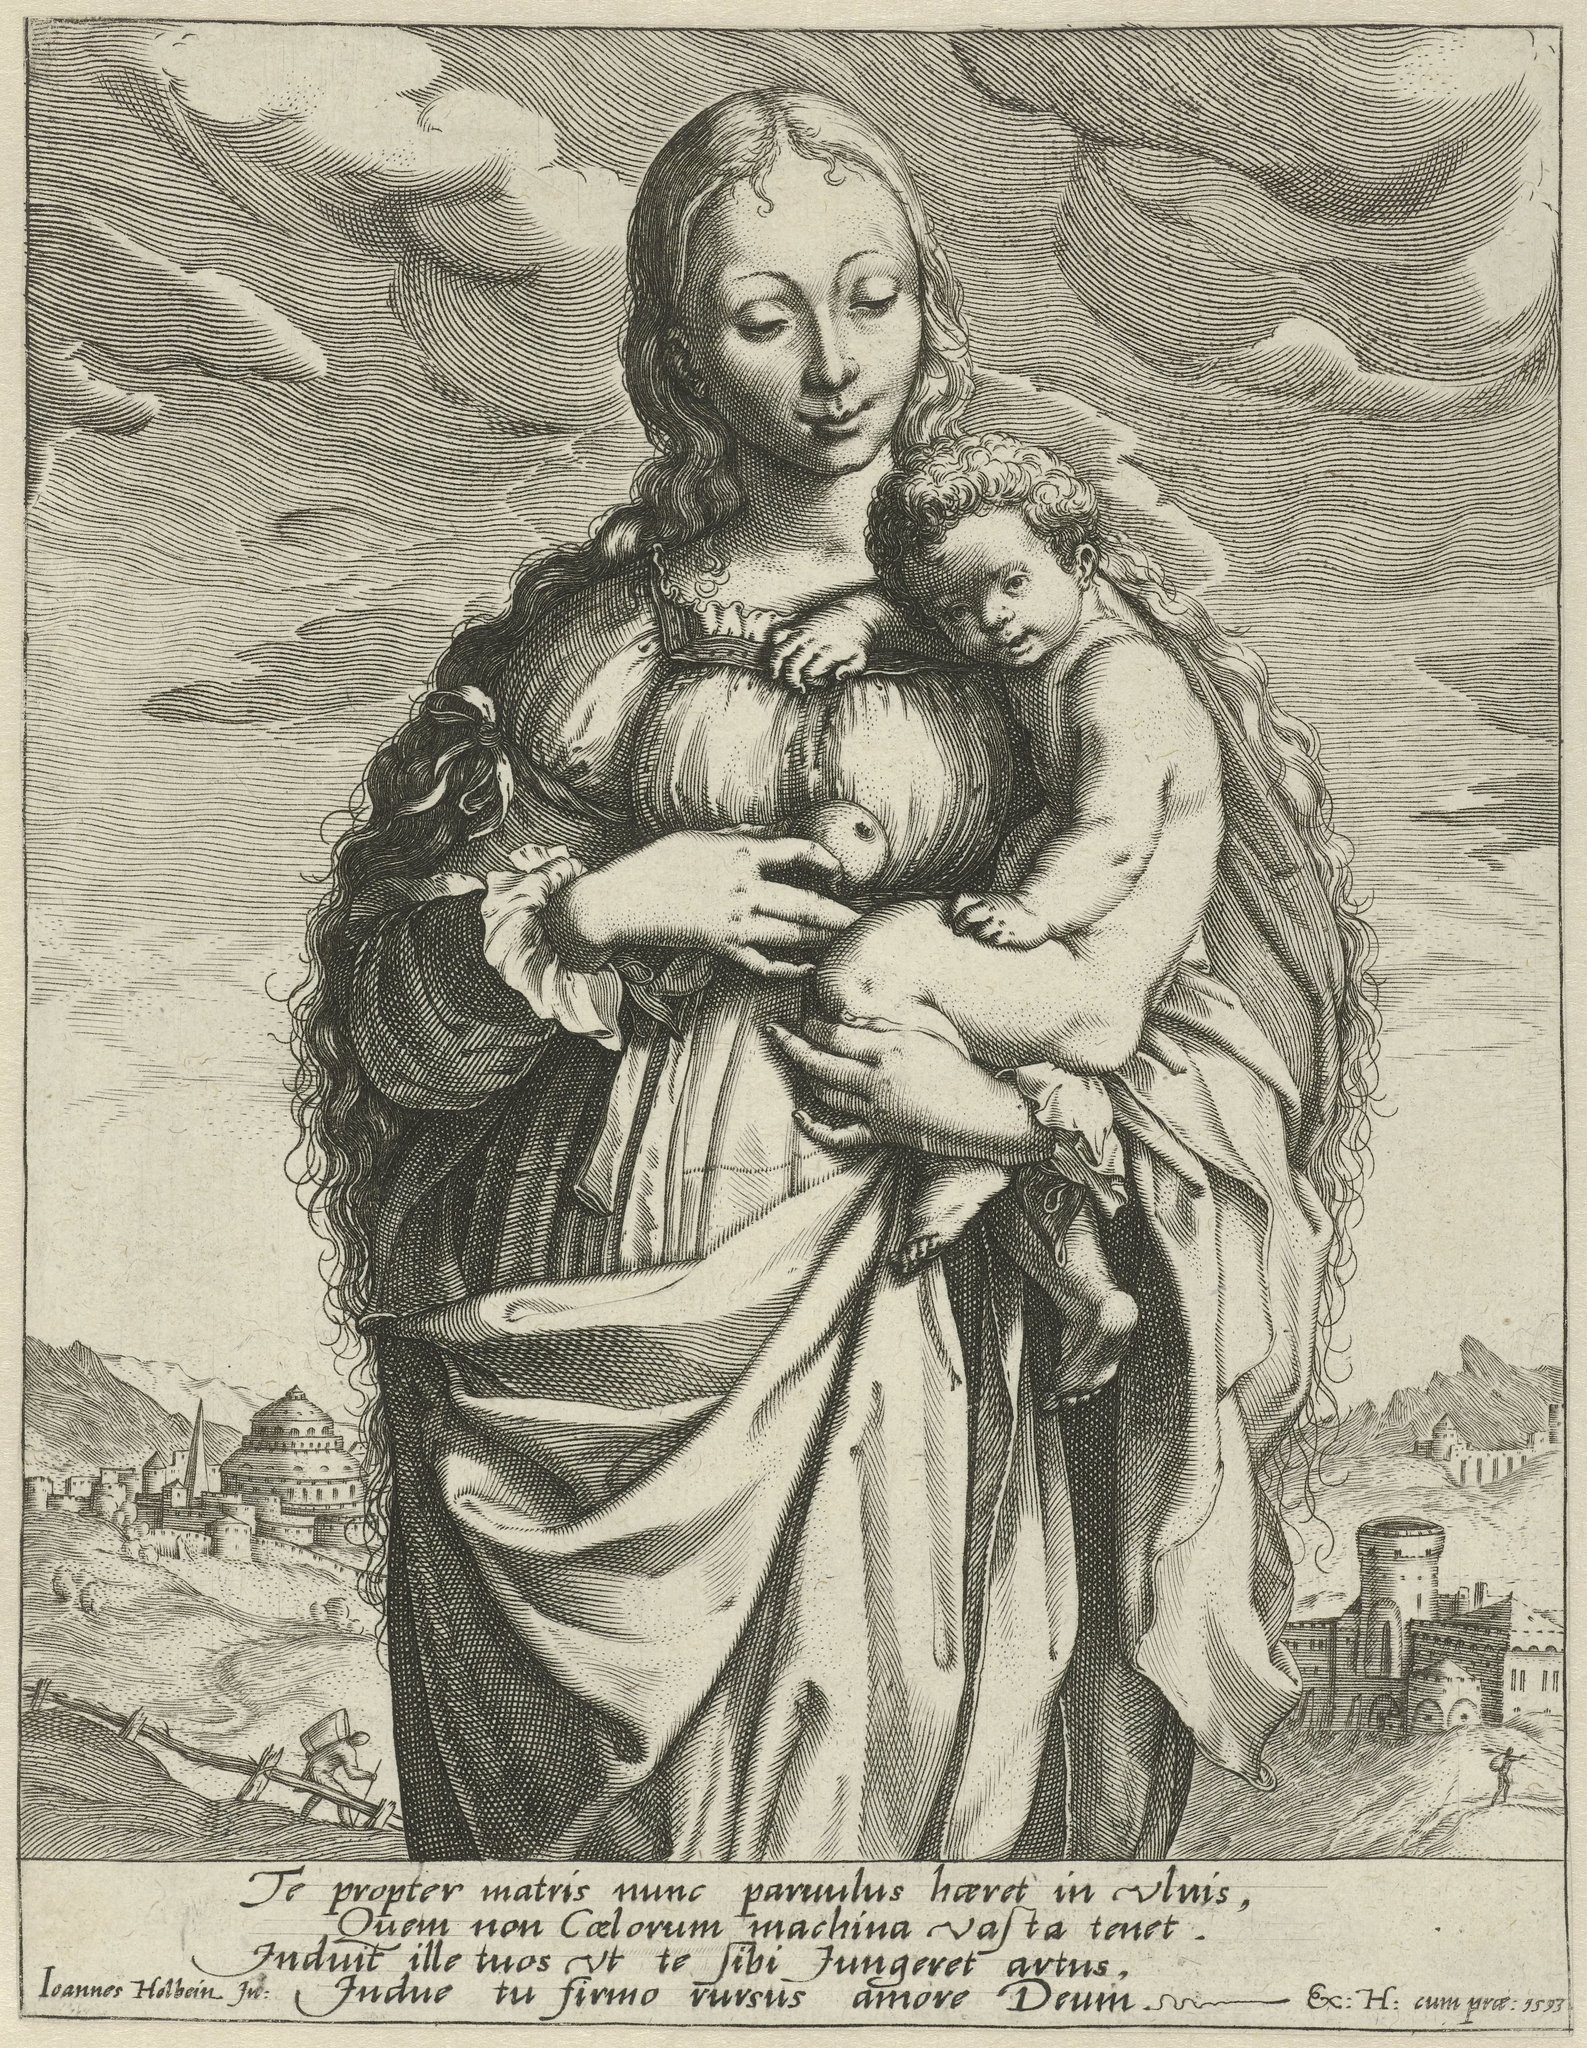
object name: print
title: Maria met kind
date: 1593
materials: paper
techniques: engraving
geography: antwerp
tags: mary standing (or half-length), the christ-child on her arm (christ-child to mary's left)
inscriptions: collector's mark: Lugt 654, collector's mark: Lugt 2228, collector's mark: Lugt 2760, collector's mark: ‘OSWALD STEIN’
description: Maria ten halven lijve. Op haar linkerarm het Christuskind. In haar rechterhand een appel. Op de achtergrond een landschap met een kasteel en een stad. De prent heeft een Latijns onderschrift.